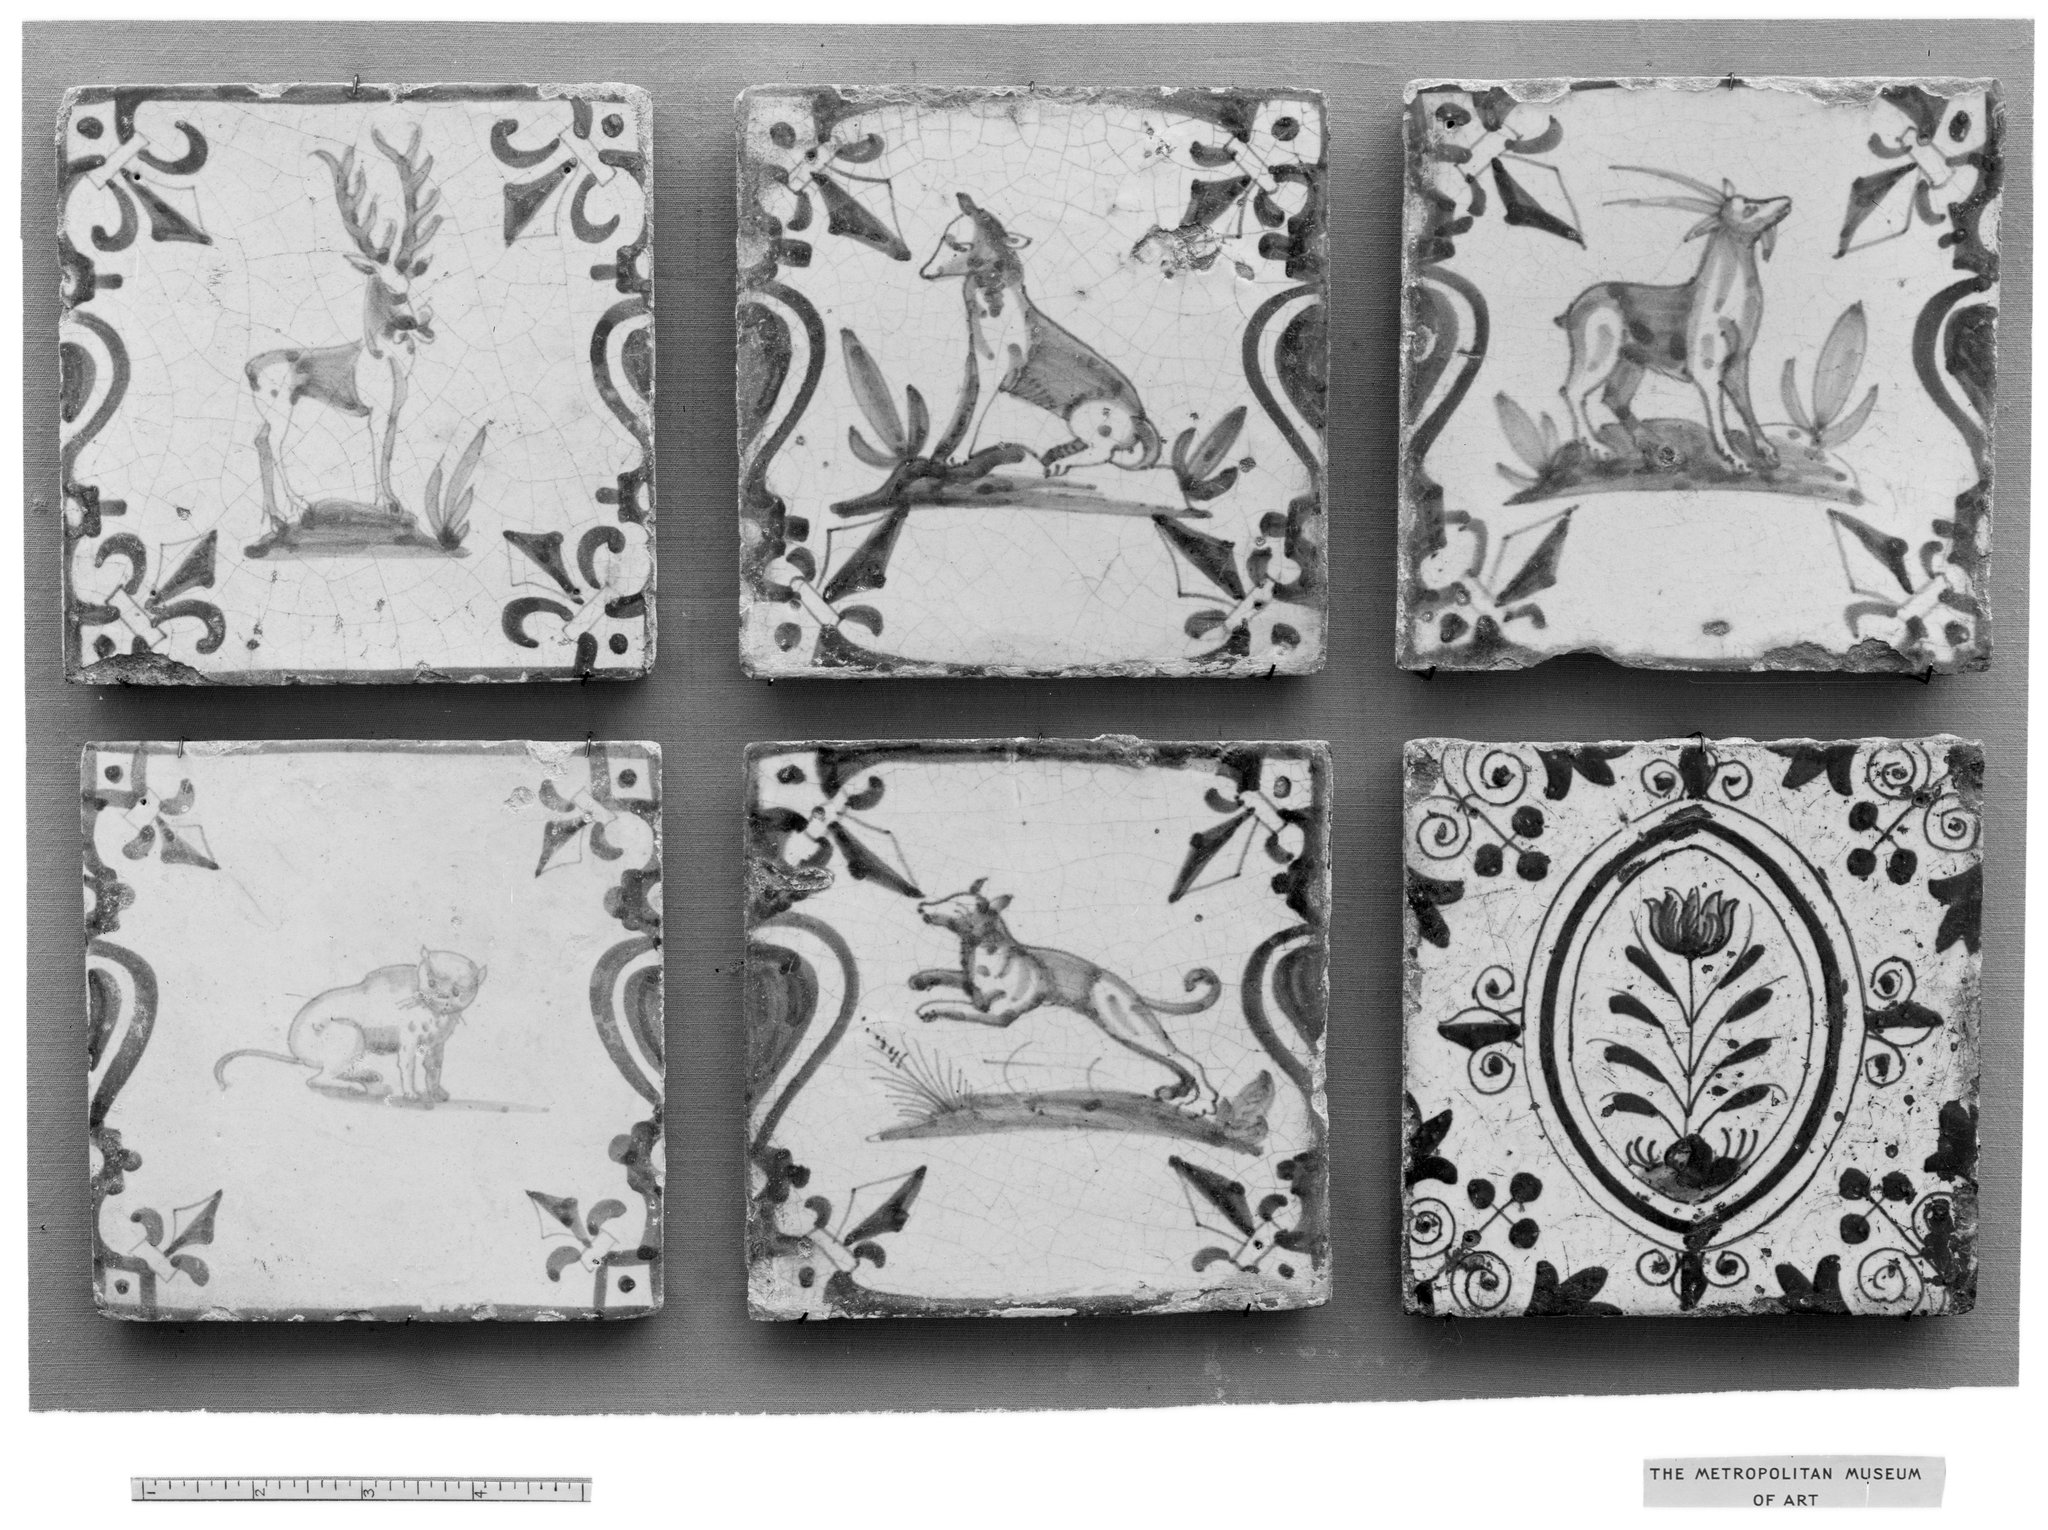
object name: tile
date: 1620-1640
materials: earthenware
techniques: glazing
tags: cats,deer,dogs,goats,flowers